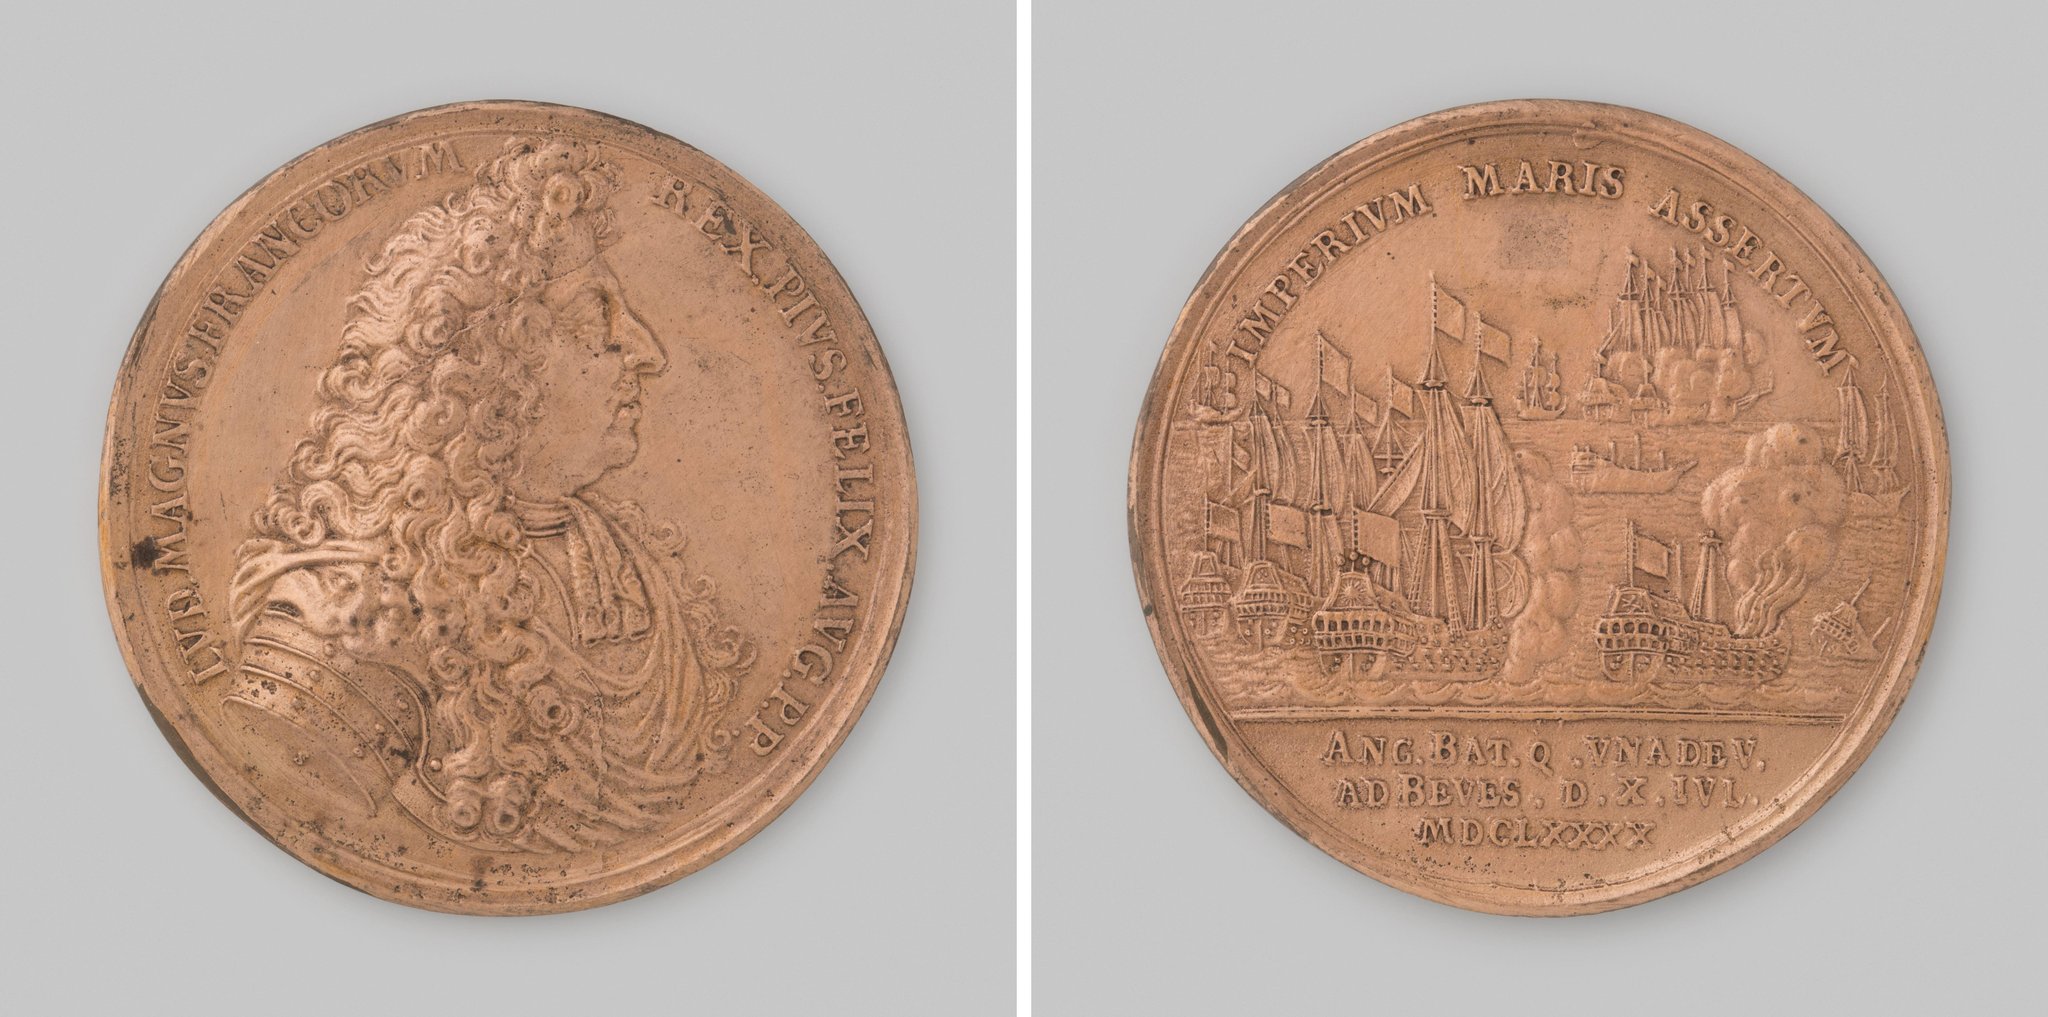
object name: history medal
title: Vernieling van Engelse en Nederlandse vloten door de Fransen 1690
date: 1690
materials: copper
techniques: casting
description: Gegoten koperen penning, op de voorzijde het borstbeeld van Lodewijk XIV met omschrift, op de keerzijde een zeeslag met omschrift en afsnedetekst.